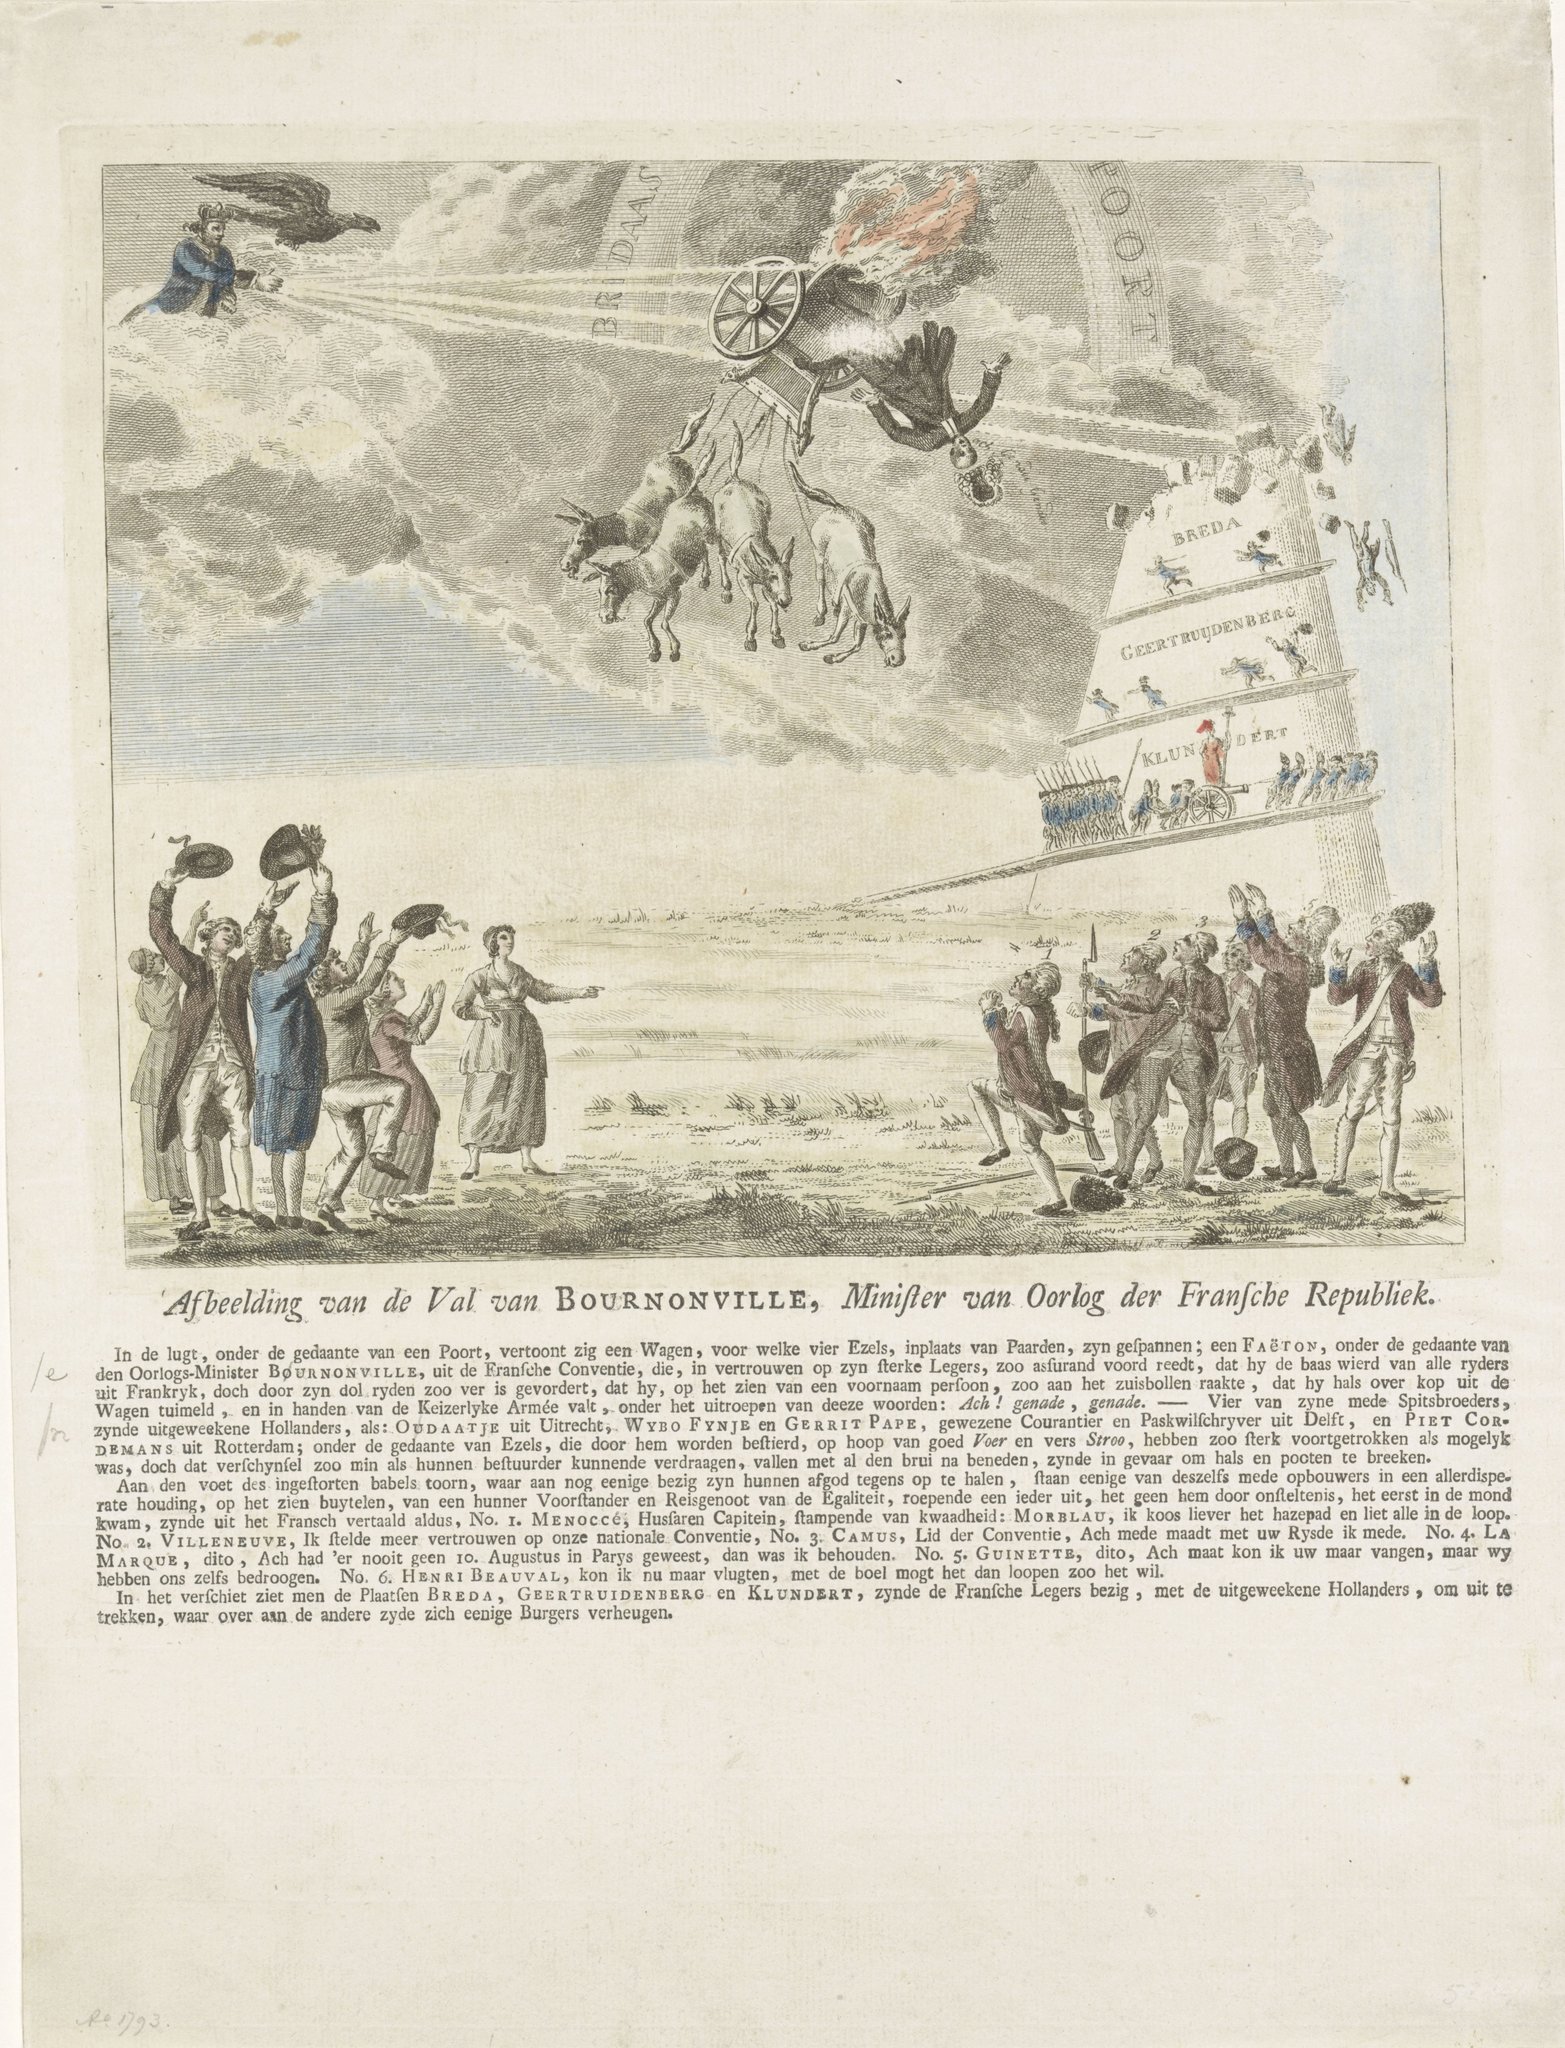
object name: print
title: Spotprent op de val van Beurnonville, de Franse minister van Oorlog, 1793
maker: Anonymous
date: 1788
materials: paper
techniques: engraving, etching, hand coloring, letterpress printing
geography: northern netherlands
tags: fall of phaethon; he is struck by a thunderbolt of jupiter, klundert, geertruidenberg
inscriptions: collector's mark: Lugt 2228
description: Spotprent op de gevangenneming van Pierre Riel de Beurnonville, de Franse minister van Oorlog, te St. Amant dankzij het verraad van de overgelopen Dumouriez. De val van de Beurnonville afgebeeld als de val van Phaëthon. De zonnewagen getrokken door vier ezels die patriotten (Oudaatje, Wybo Fijnje, Gerrit Pape en Pieter Cordemans) voorstellen. Rechts een afbrokkelende toren van Babel met de namen van Breda, Geertruidenberg en Klundert. Rechts ziet een groepje Fransen met afgrijzen toe, links juichende Hollanders. Op het blad onder de plaat een beschrijving.